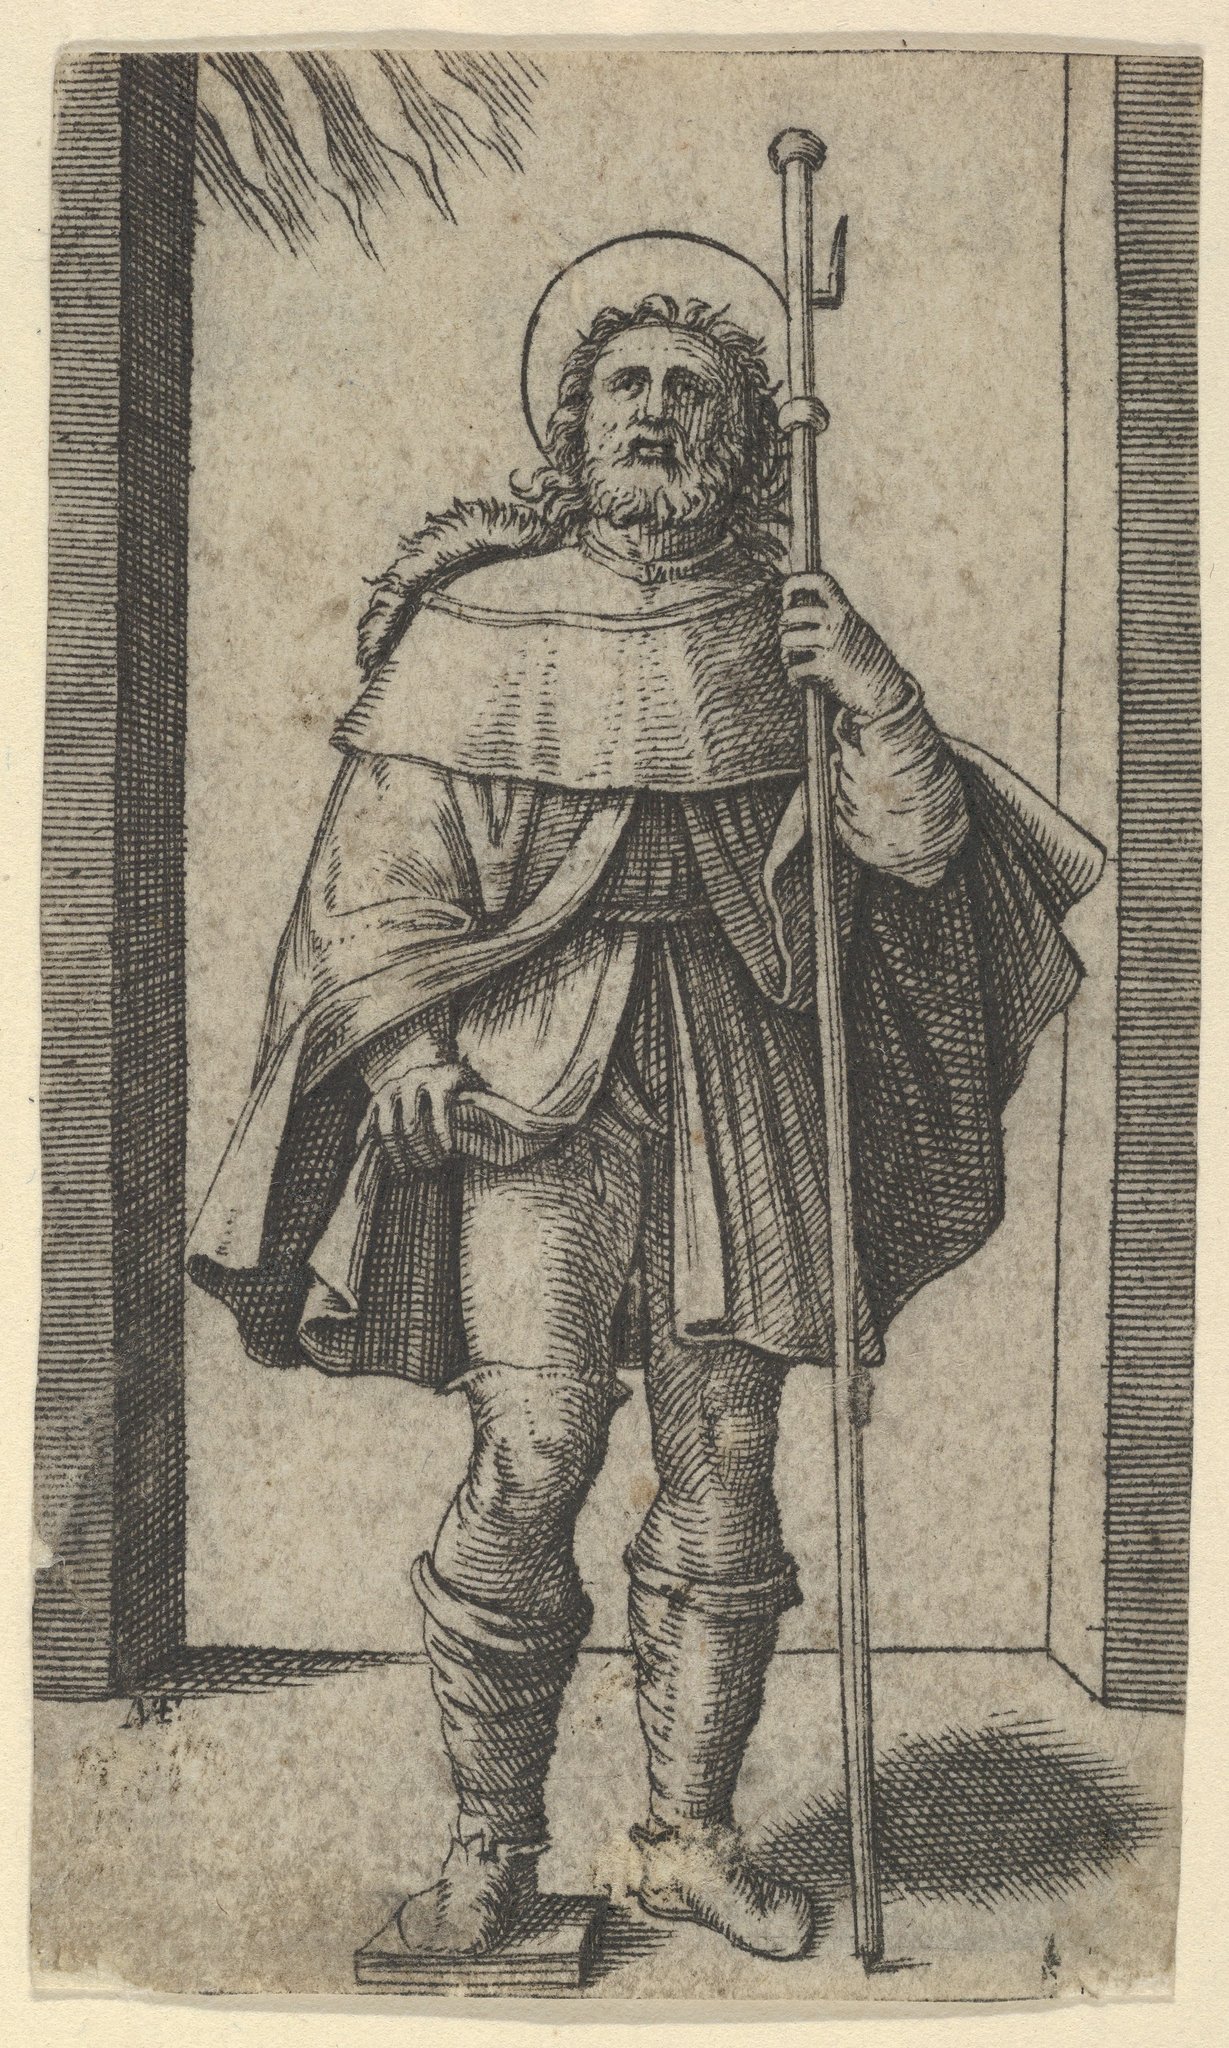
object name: print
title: Saint Roch staff in his left hand, from "Piccoli Santi" (Small Saints)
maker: marcantonio raimondi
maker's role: artist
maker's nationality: italian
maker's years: 1475-1534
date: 1500-1527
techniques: engraving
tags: saints